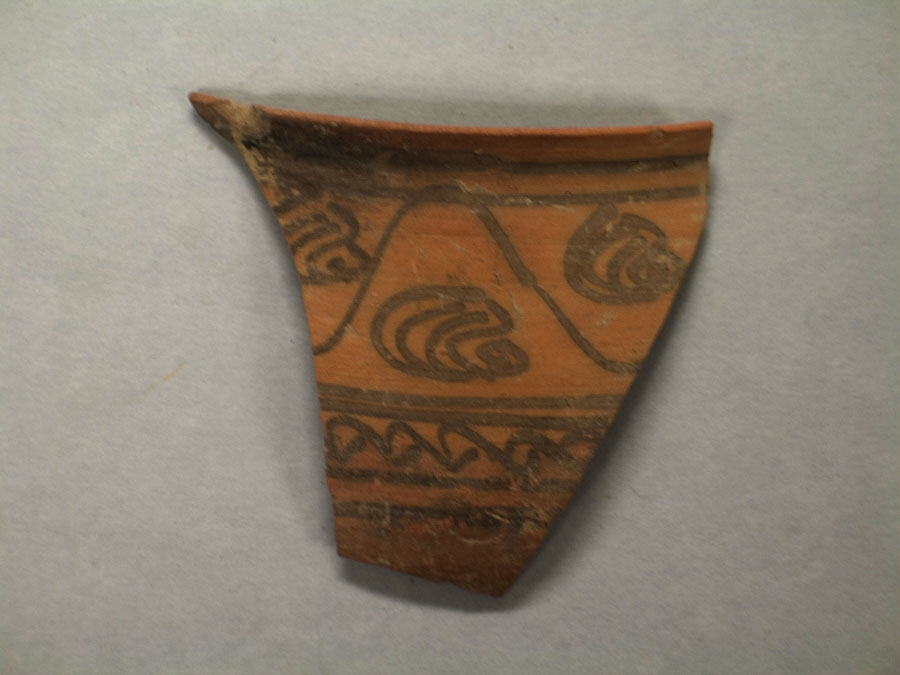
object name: shard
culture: pakistani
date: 301-500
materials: terracotta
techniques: painting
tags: gandhara